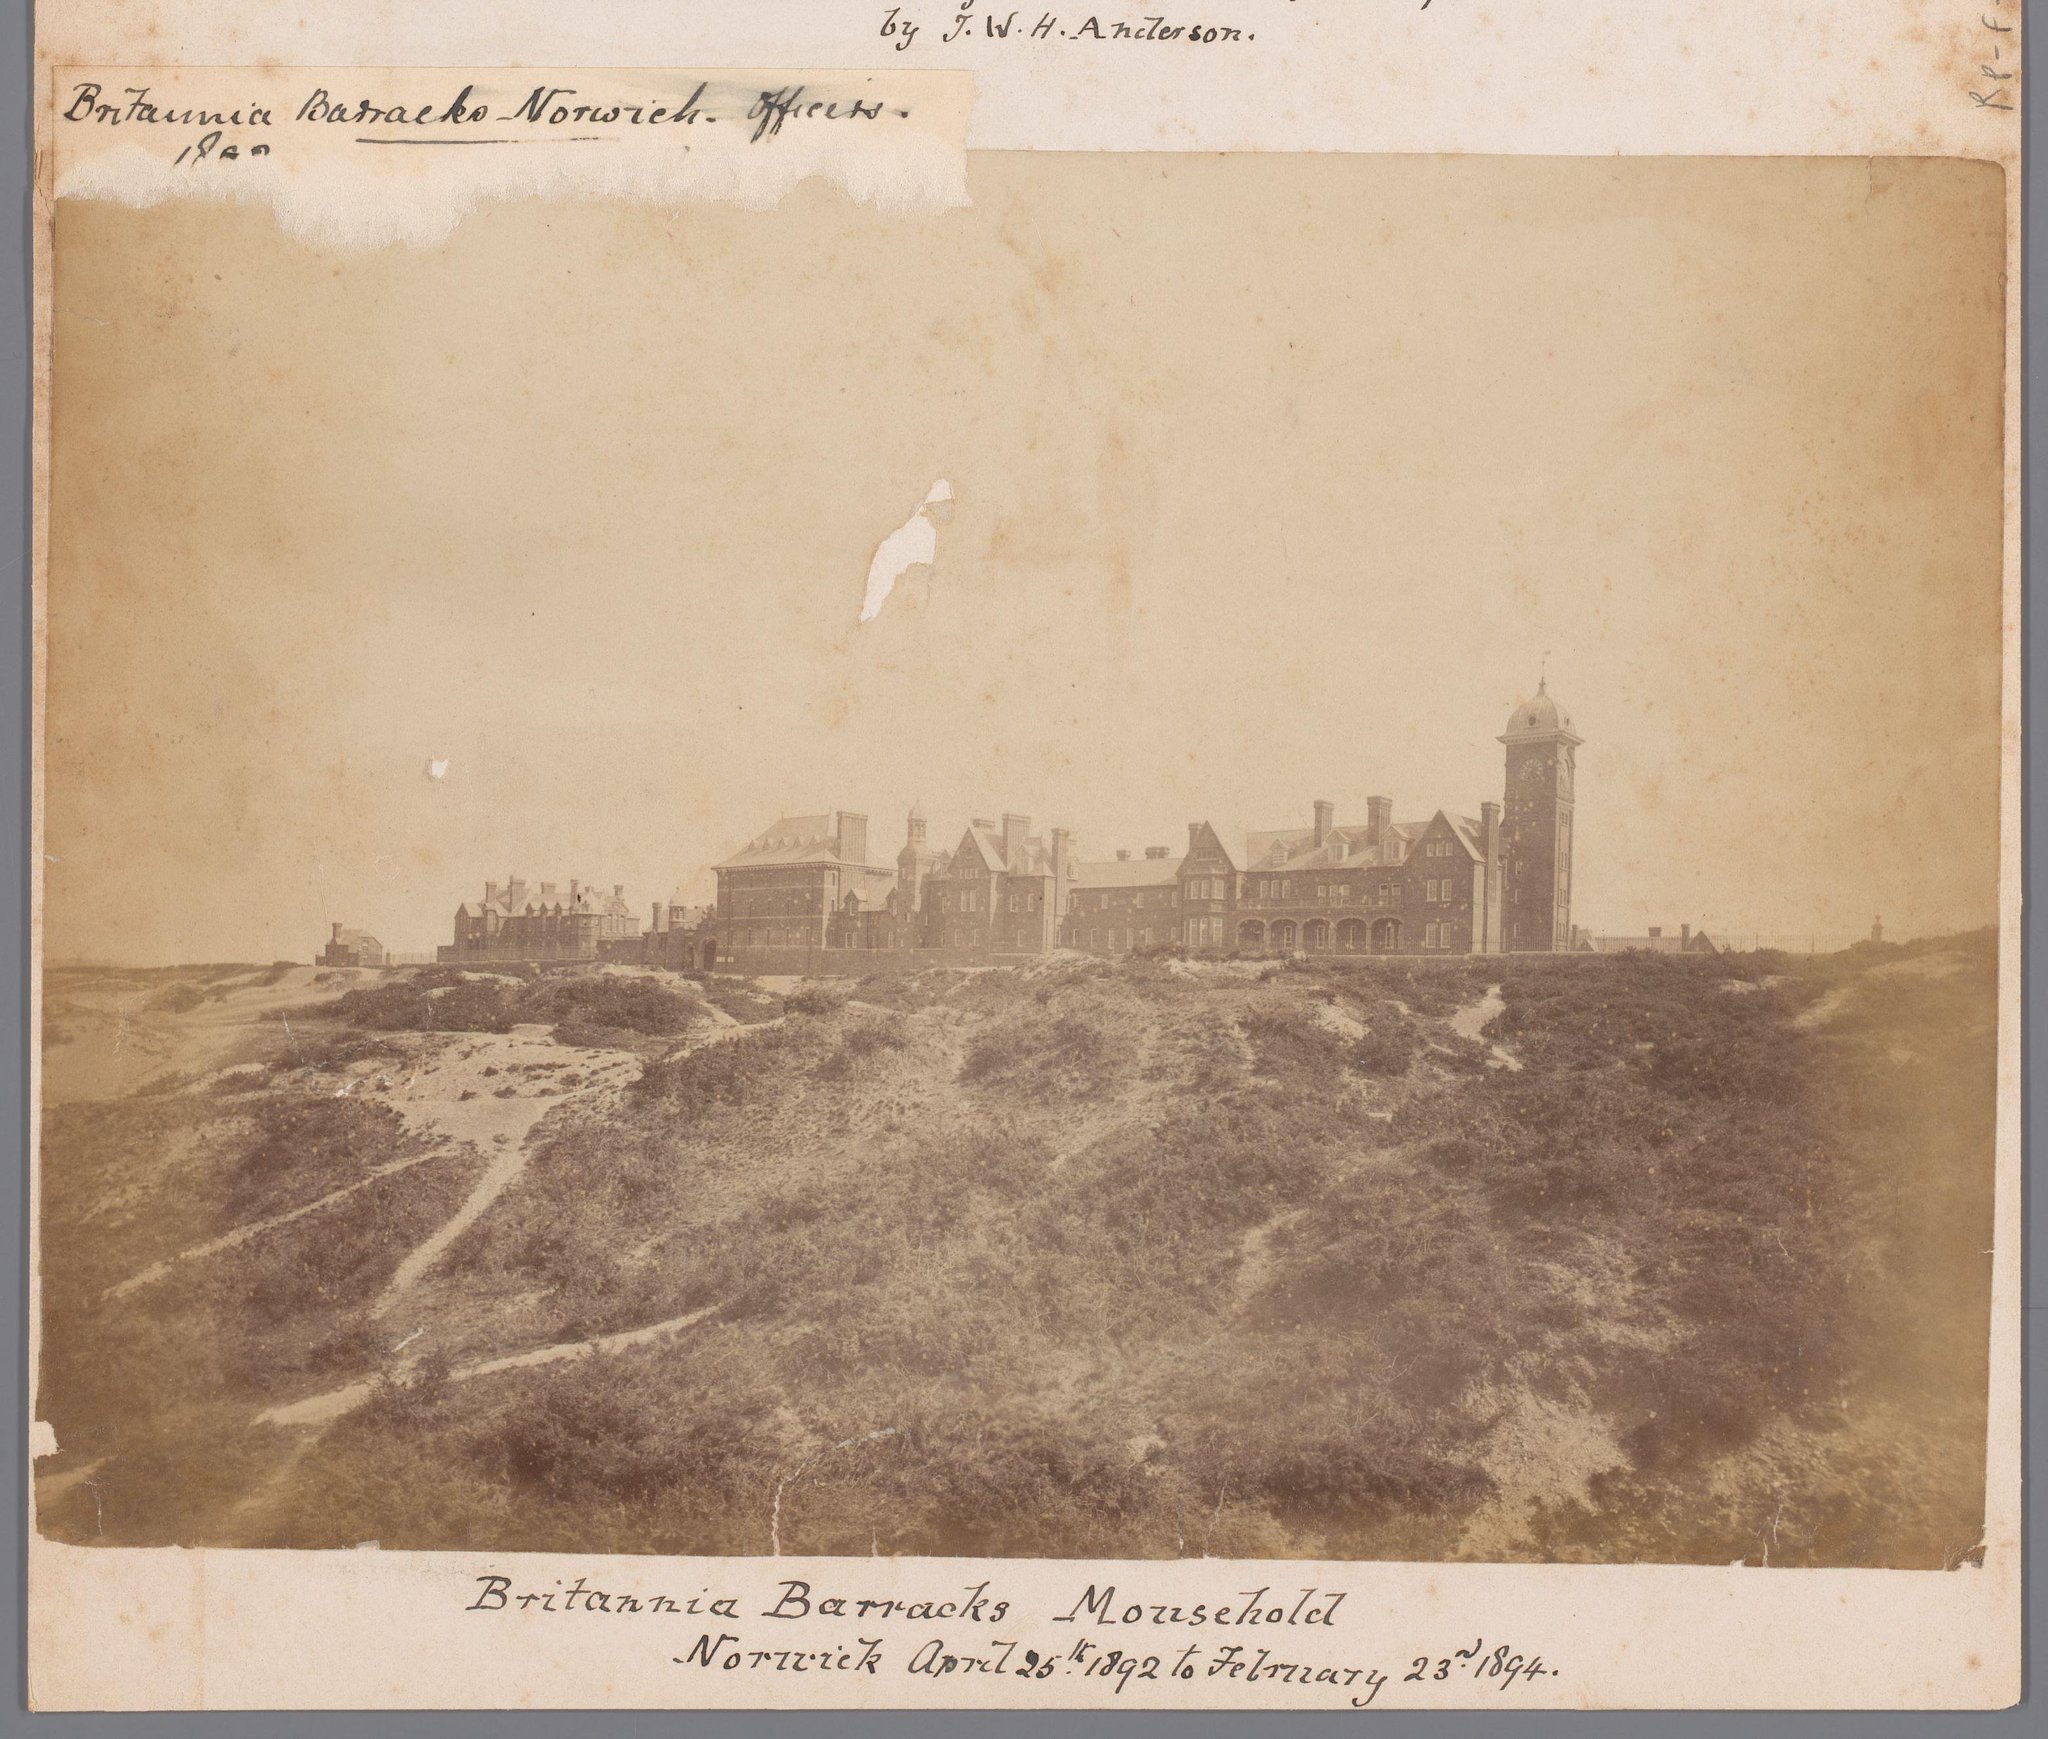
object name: photograph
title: Britannia Barracks, Mousehold Heath, Norwich, Engeland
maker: Anonymous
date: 1892-1894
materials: cardboard, paper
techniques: albumen print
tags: england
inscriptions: inscription: ‘Britannia Barracks Norwich officers 18[?]’, caption: ‘Britannia Barracks Mousehold//Norwick [sic] April 26th 1892- to February 23 1894.’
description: Britannia Barracks is een groot complex, dat dienst deed als legeronderkomen en meer recent als gevangenis. Mousehold Heath is een heide- en boslandschap in het Noord-oosten van Norwich, Engeland. an area of heathland and woodland which lies in north east Norwich, England.